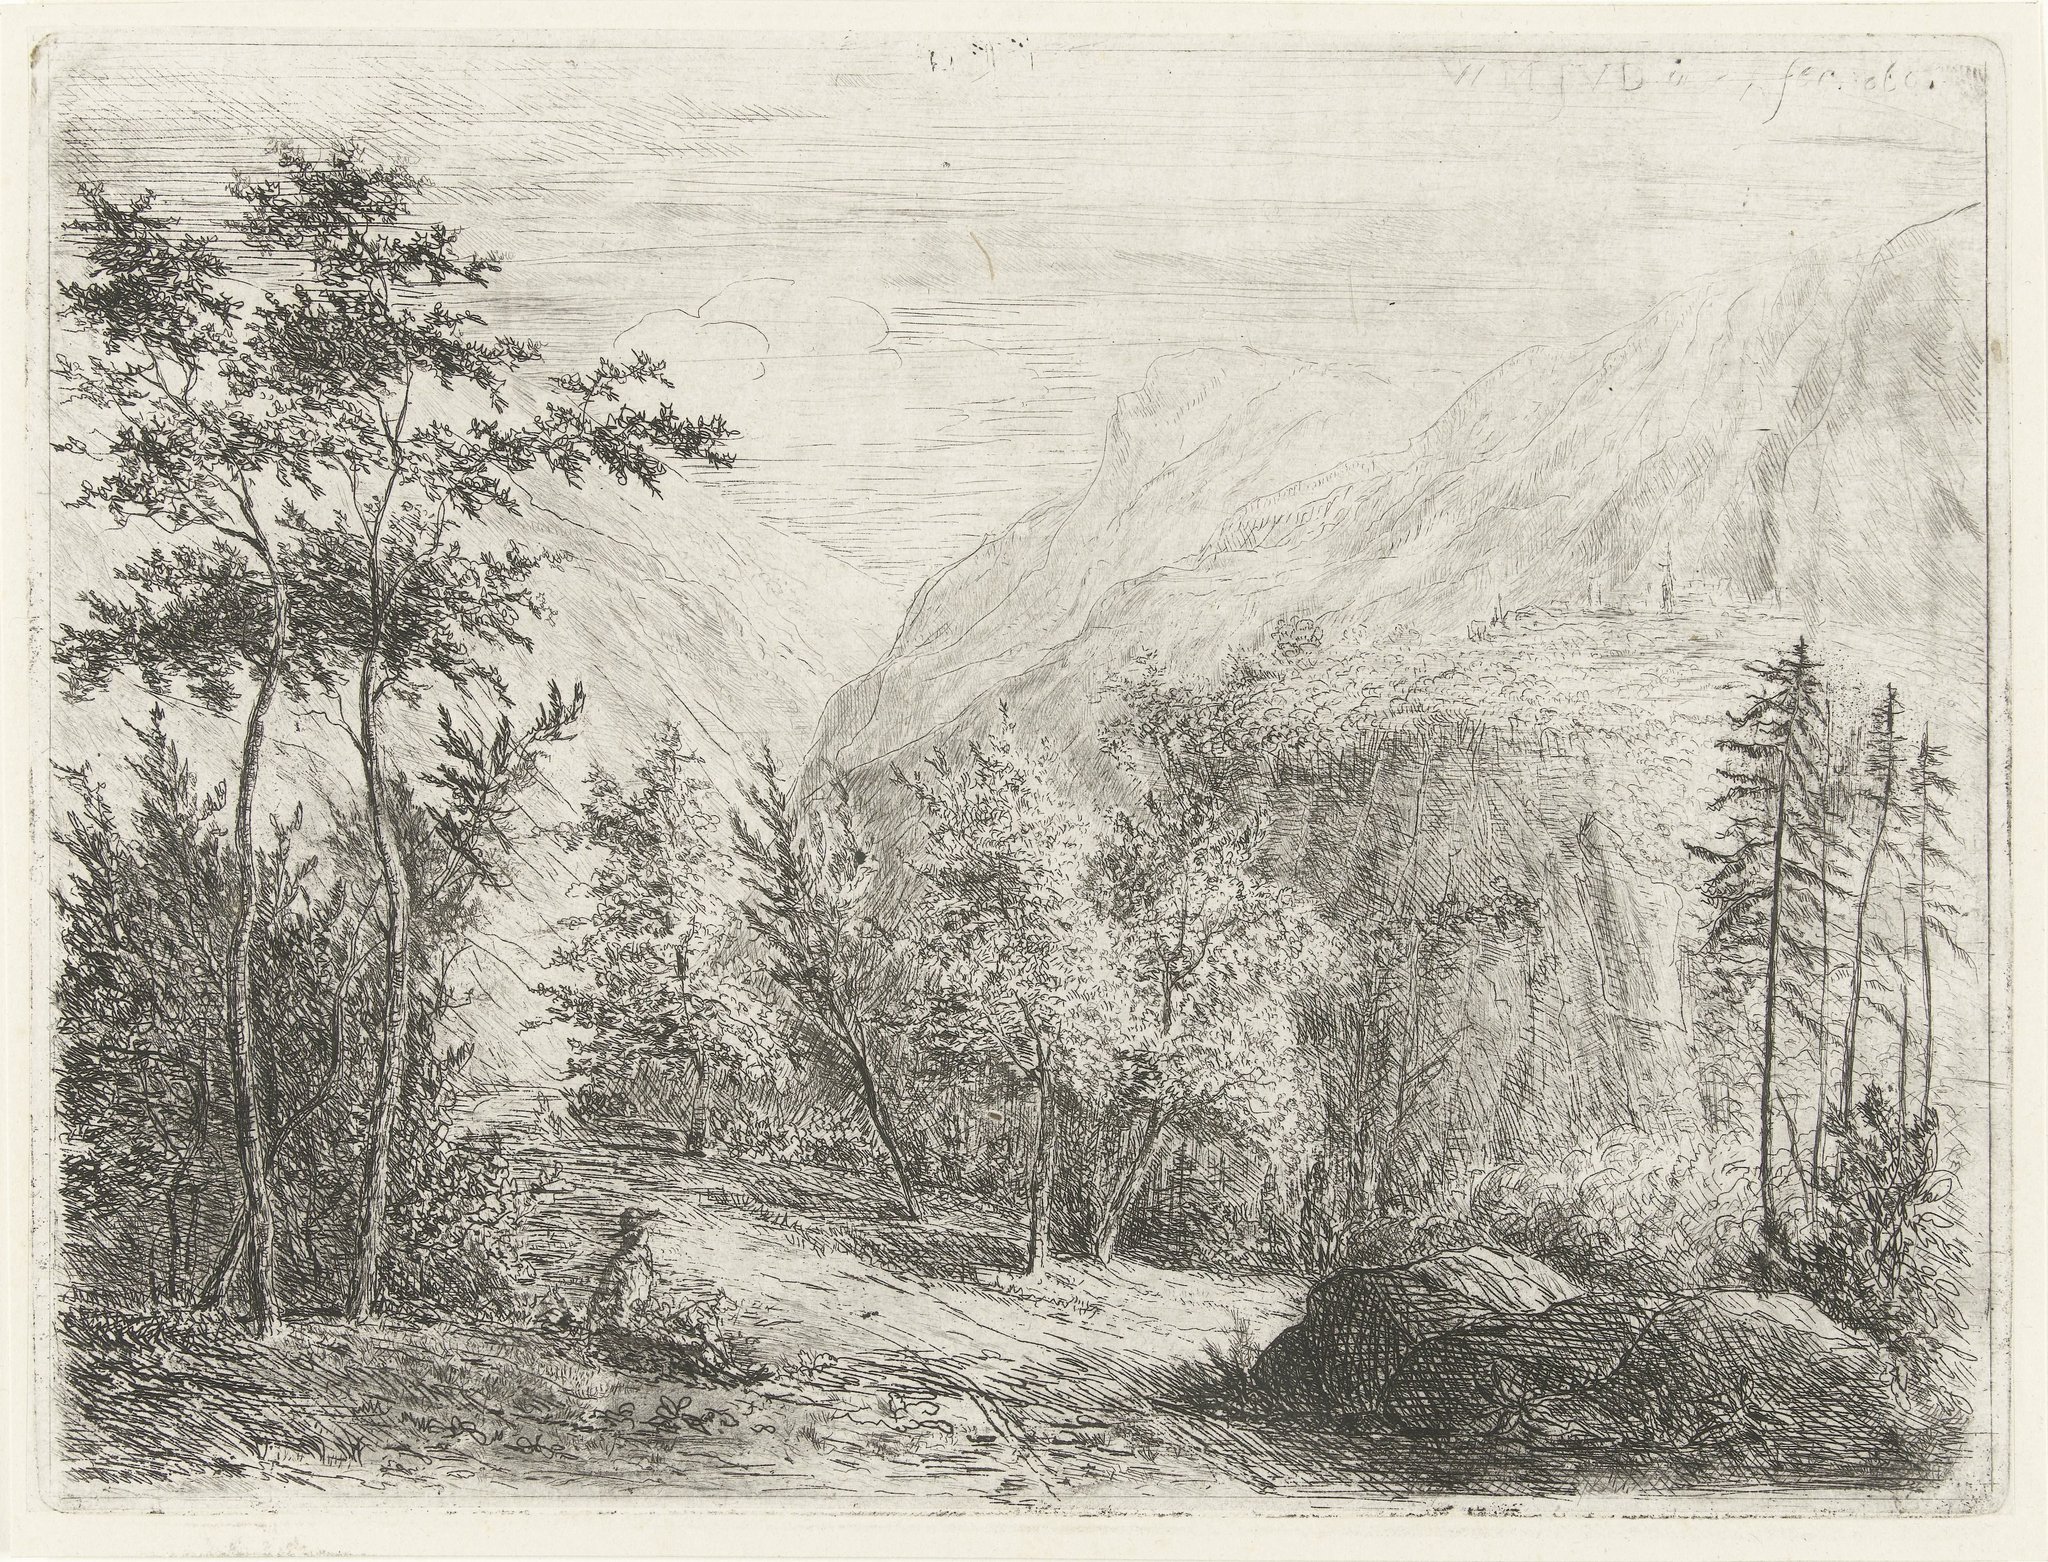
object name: print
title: Berglandschap met rustende figuur langs weg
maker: willem matthias jan van dielen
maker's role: print maker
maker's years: 1805-1867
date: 1815-1867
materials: paper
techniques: etching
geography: netherlands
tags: mountains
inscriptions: collector's mark: Lugt 2228